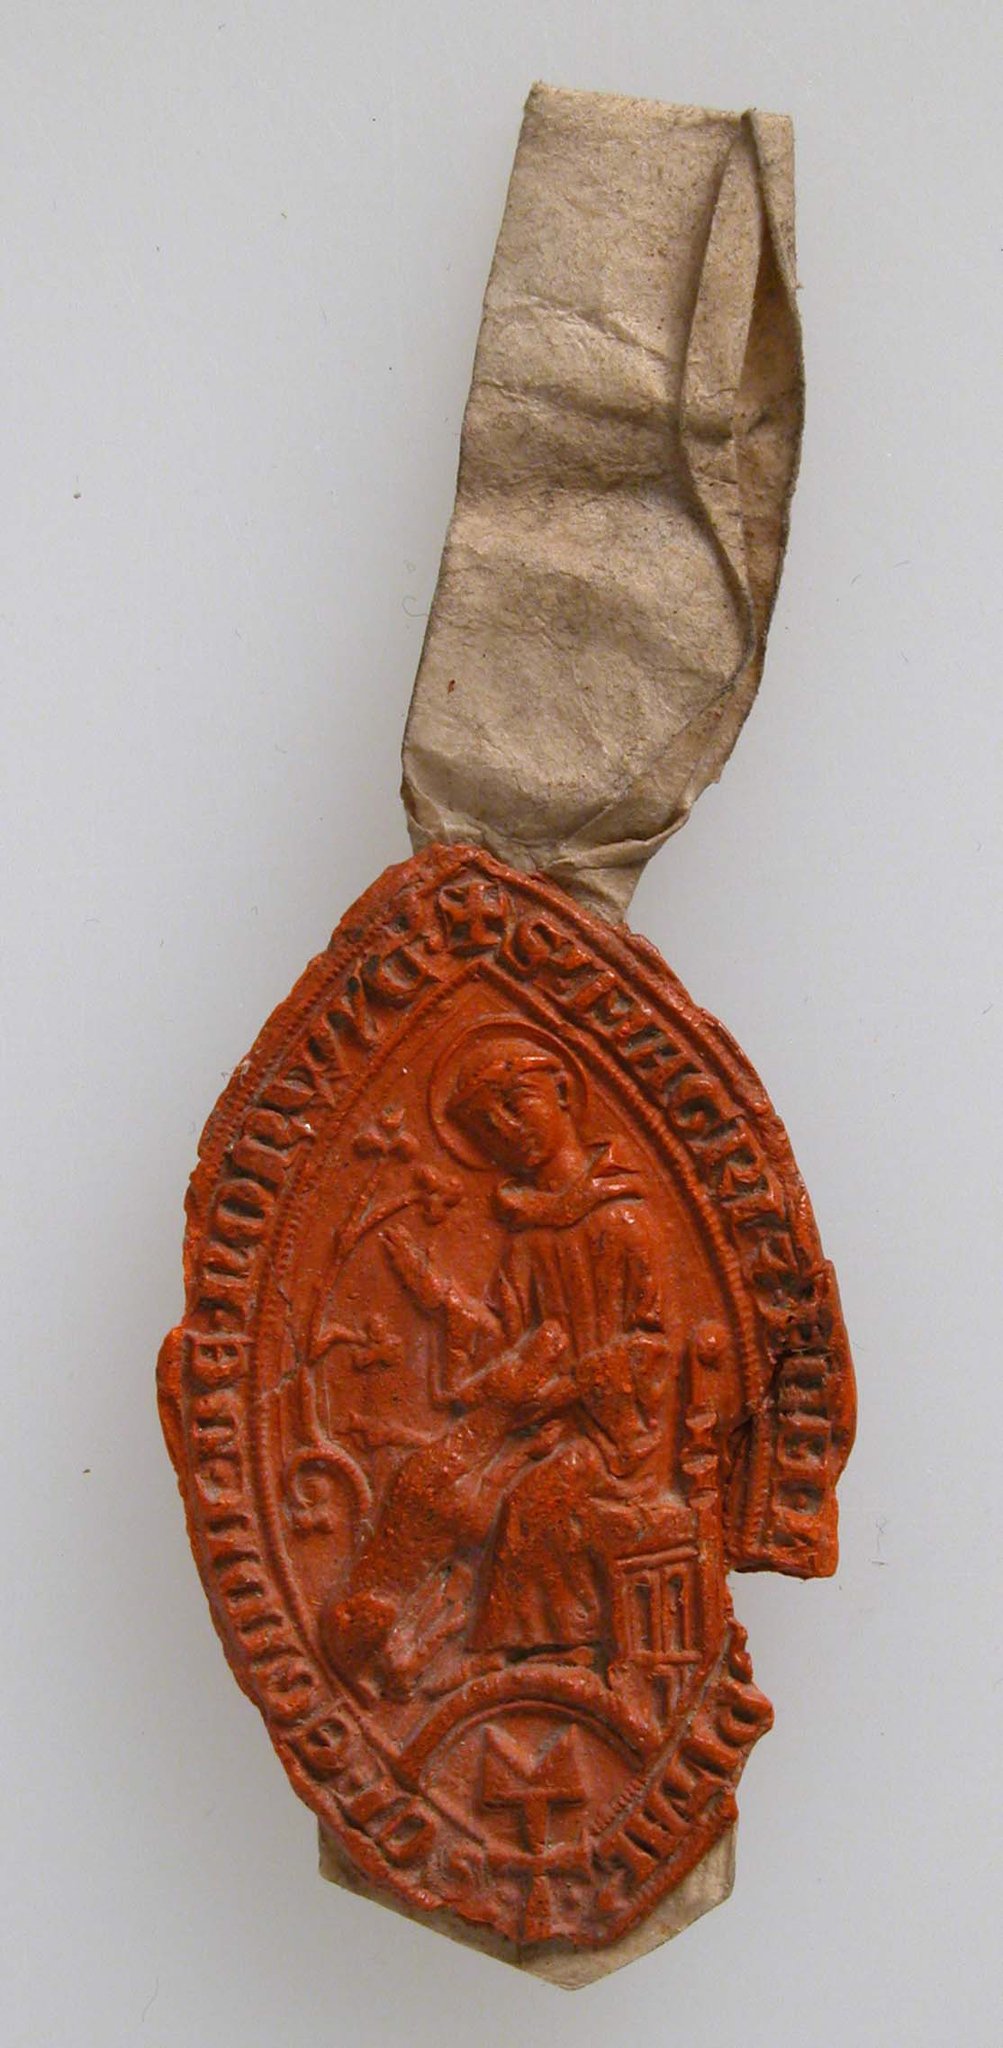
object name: seal impression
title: Seal Impression, Saint Giles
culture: british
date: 1267-1300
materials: wax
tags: men,saints